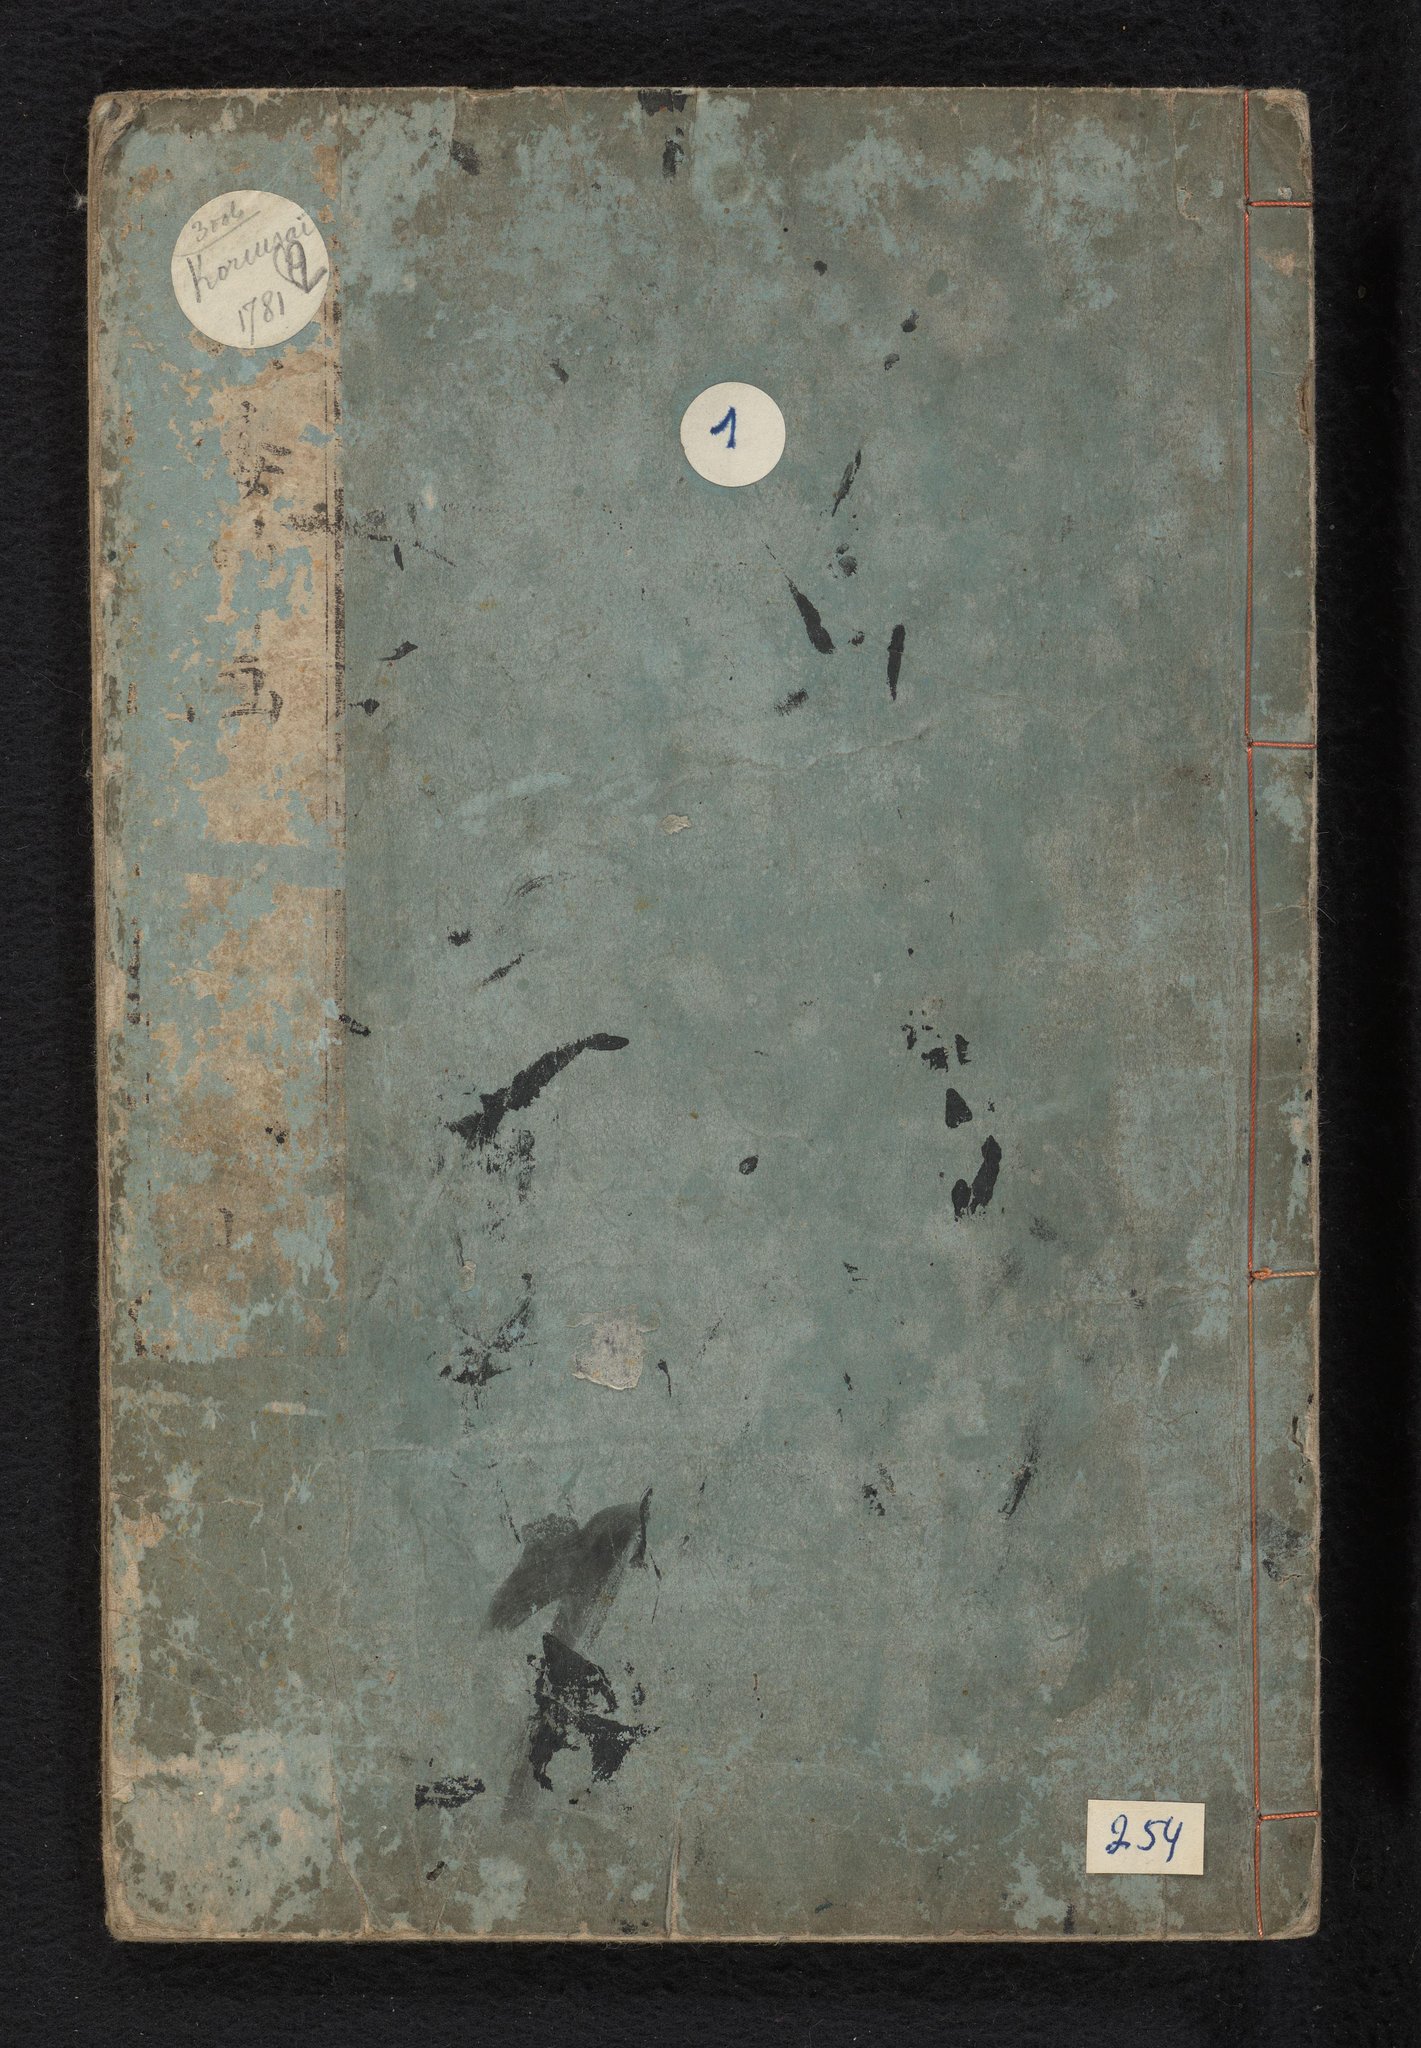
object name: book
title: Konzatsu Yamato soga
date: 1781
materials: paper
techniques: woodcut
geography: edo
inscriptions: collector's mark: ‘Nakamura Katsujiro’, collector's mark: ‘ex.libris JEAN SIEGLER’, inscription, collector's mark: ‘Hayashi Tadamasa’, collector's mark: ‘Rode rozetvorm waarin twee letters’